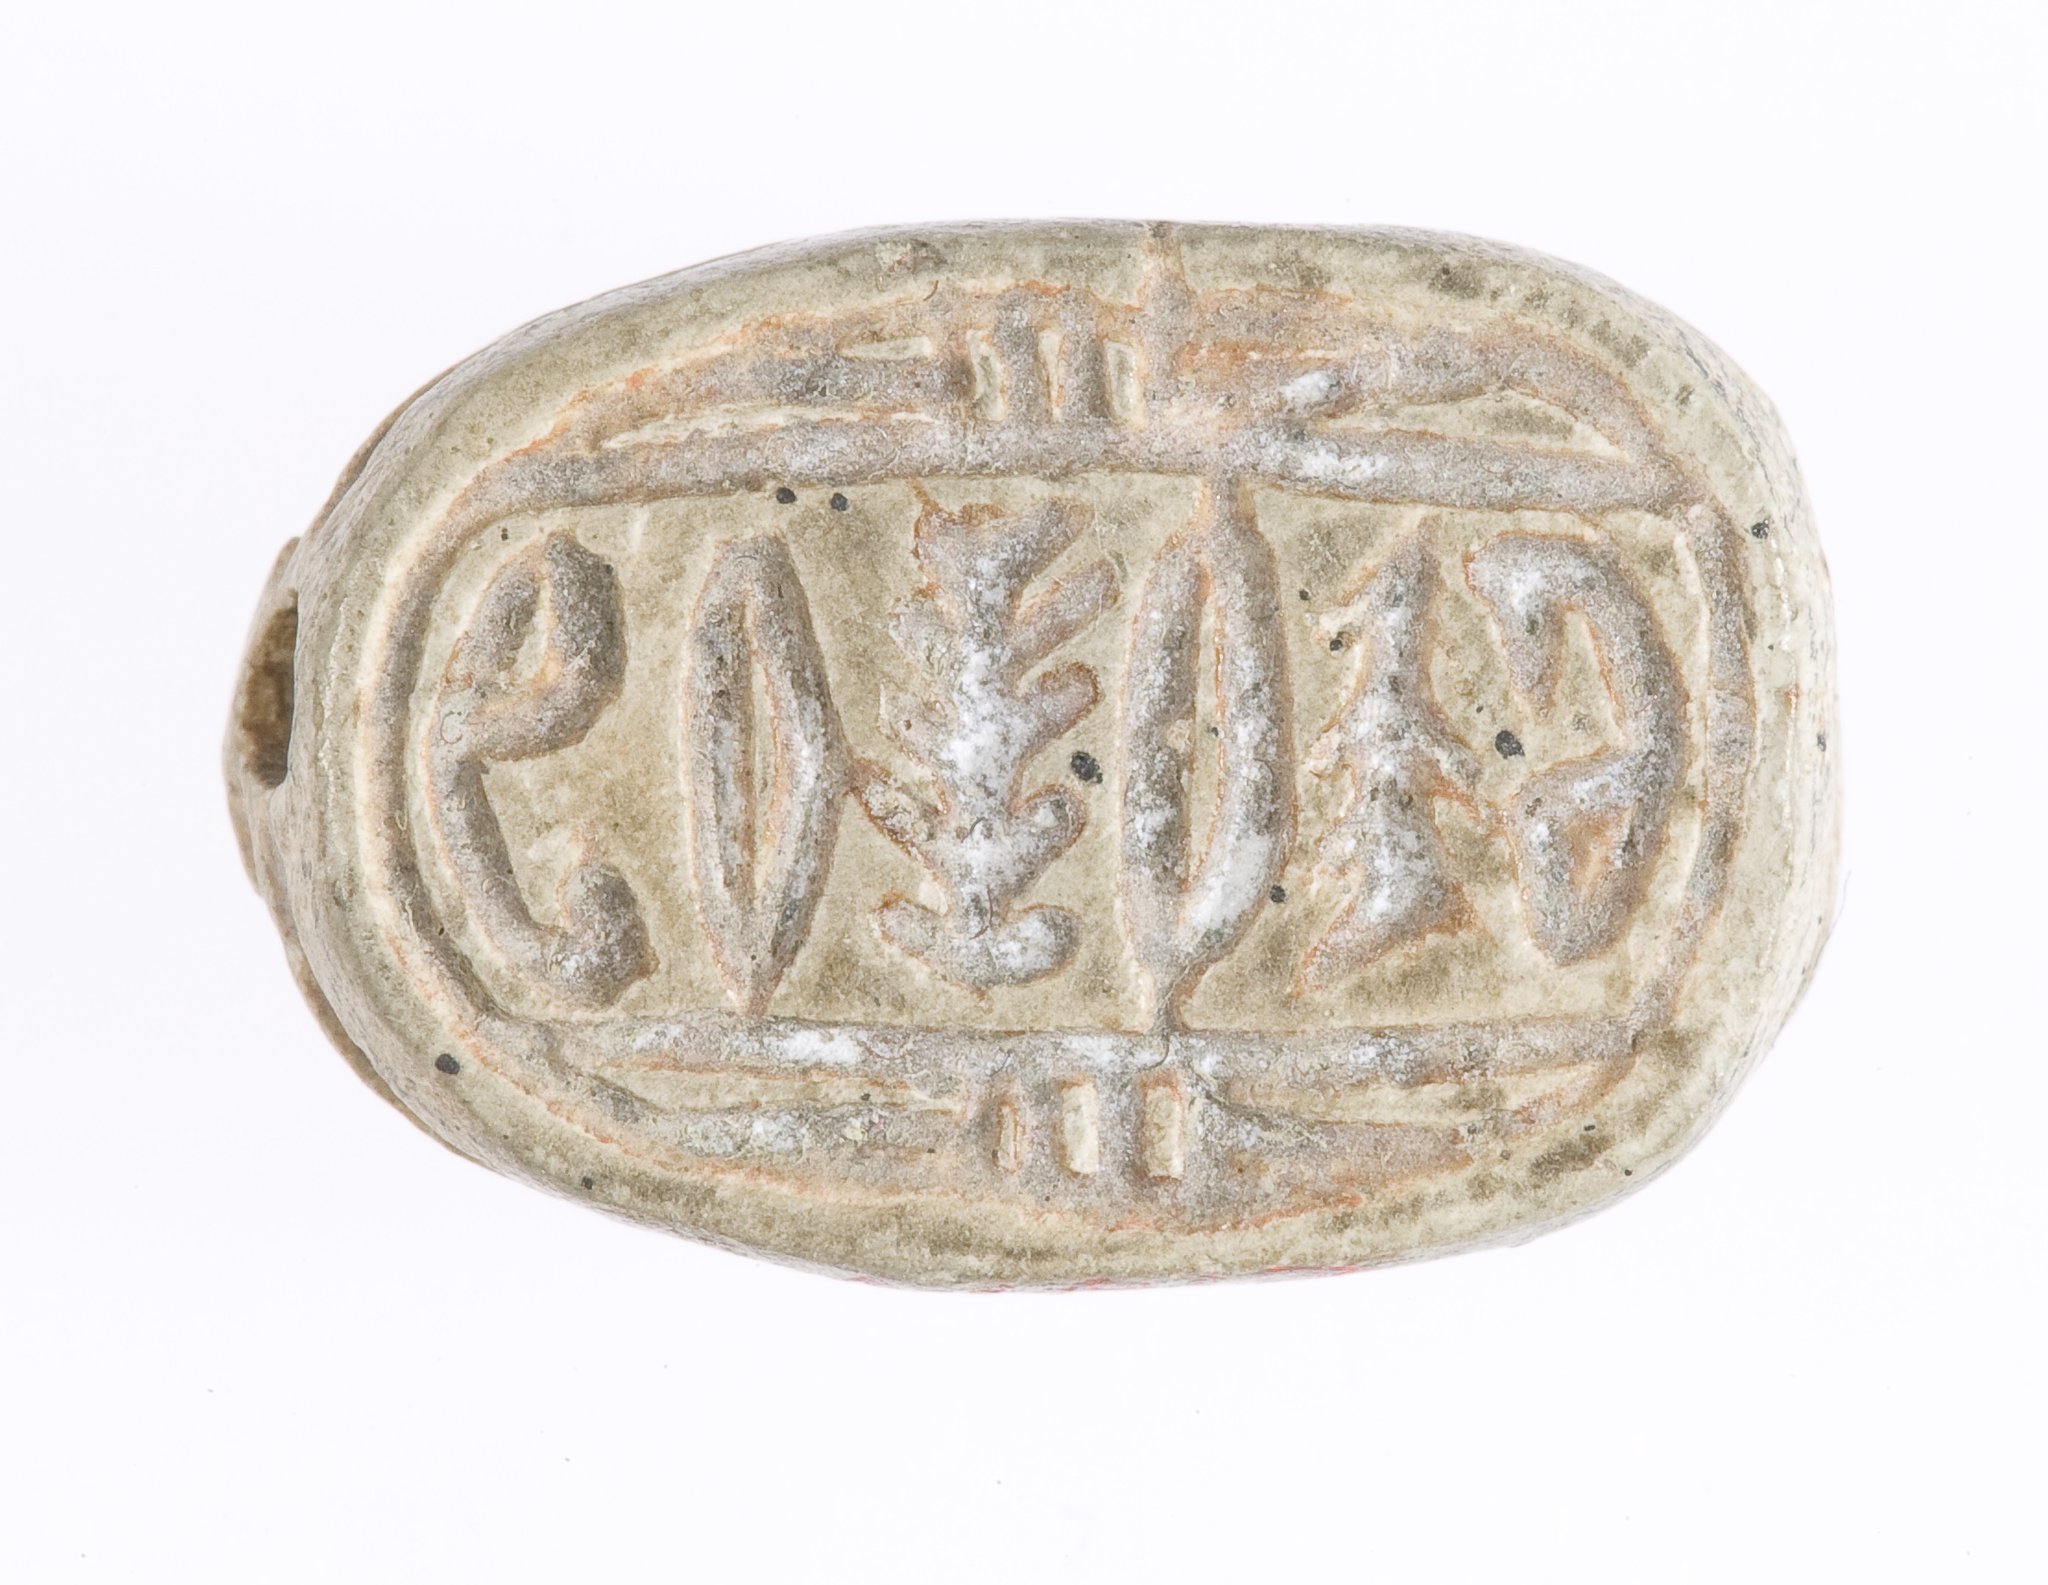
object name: scarab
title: Scarab with decorative motif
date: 1550-1458 BCE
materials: stone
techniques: glazing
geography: egypt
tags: scarabs